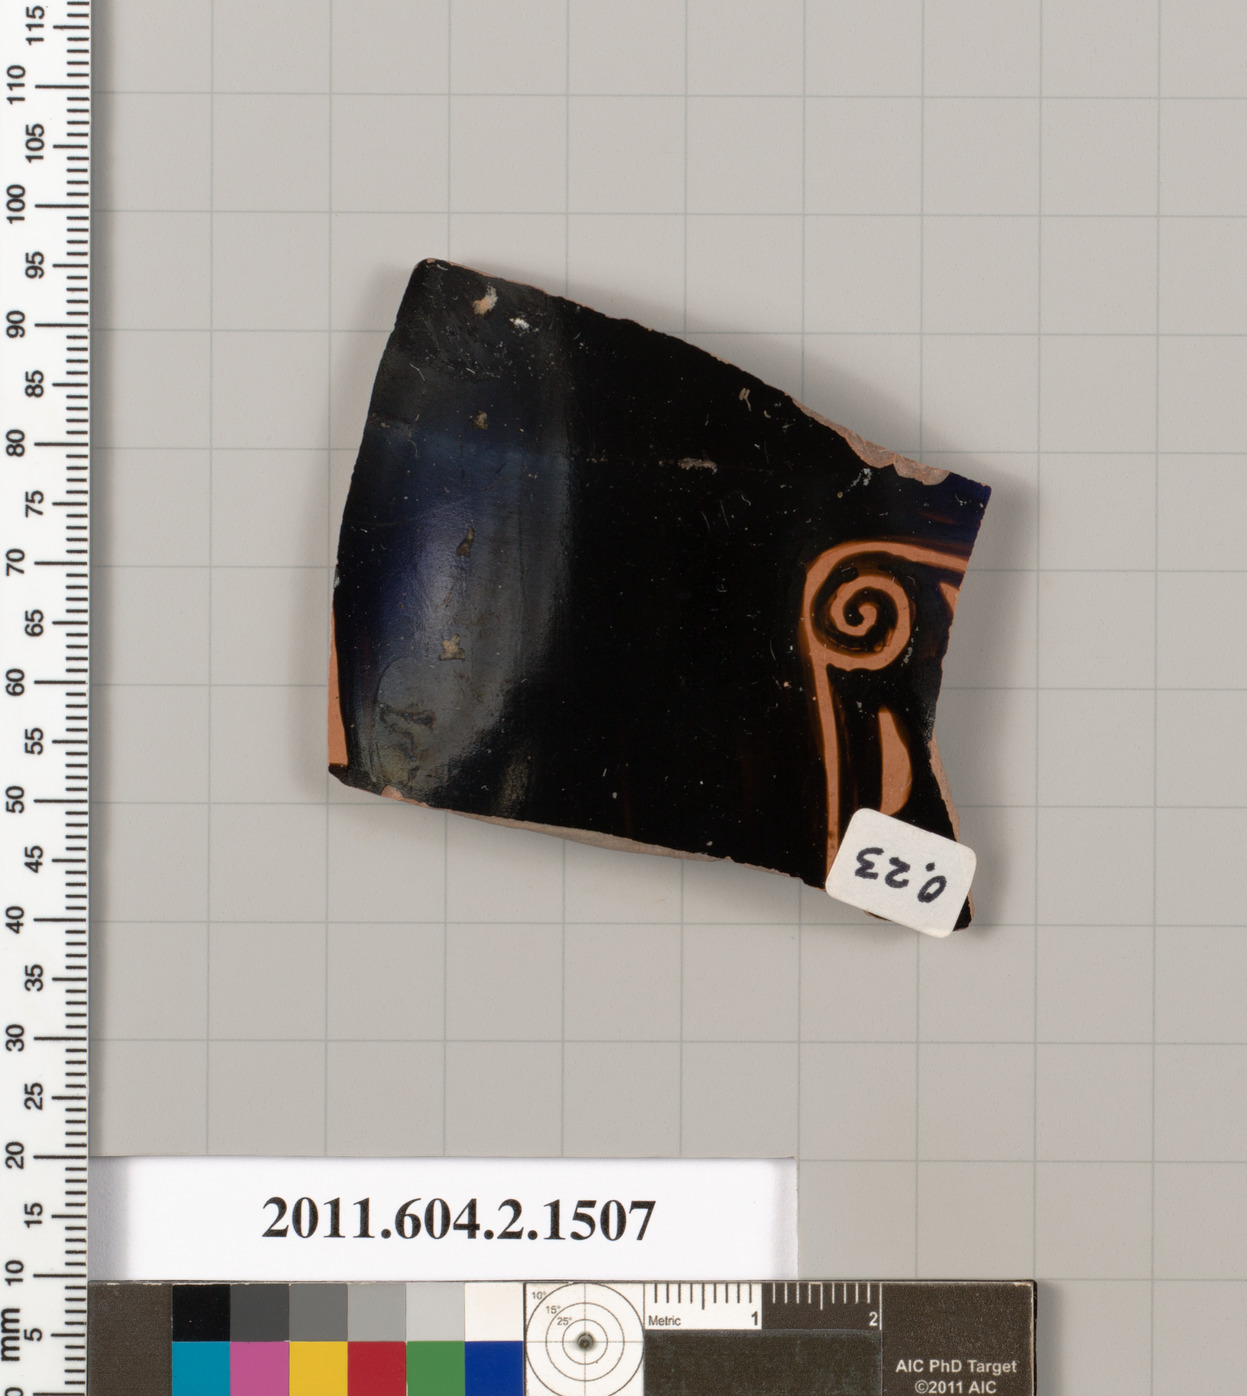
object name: skyphos fragment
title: Terracotta fragment of a skyphos (deep drinking cup)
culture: greek, attic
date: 475-440 BCE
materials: terracotta